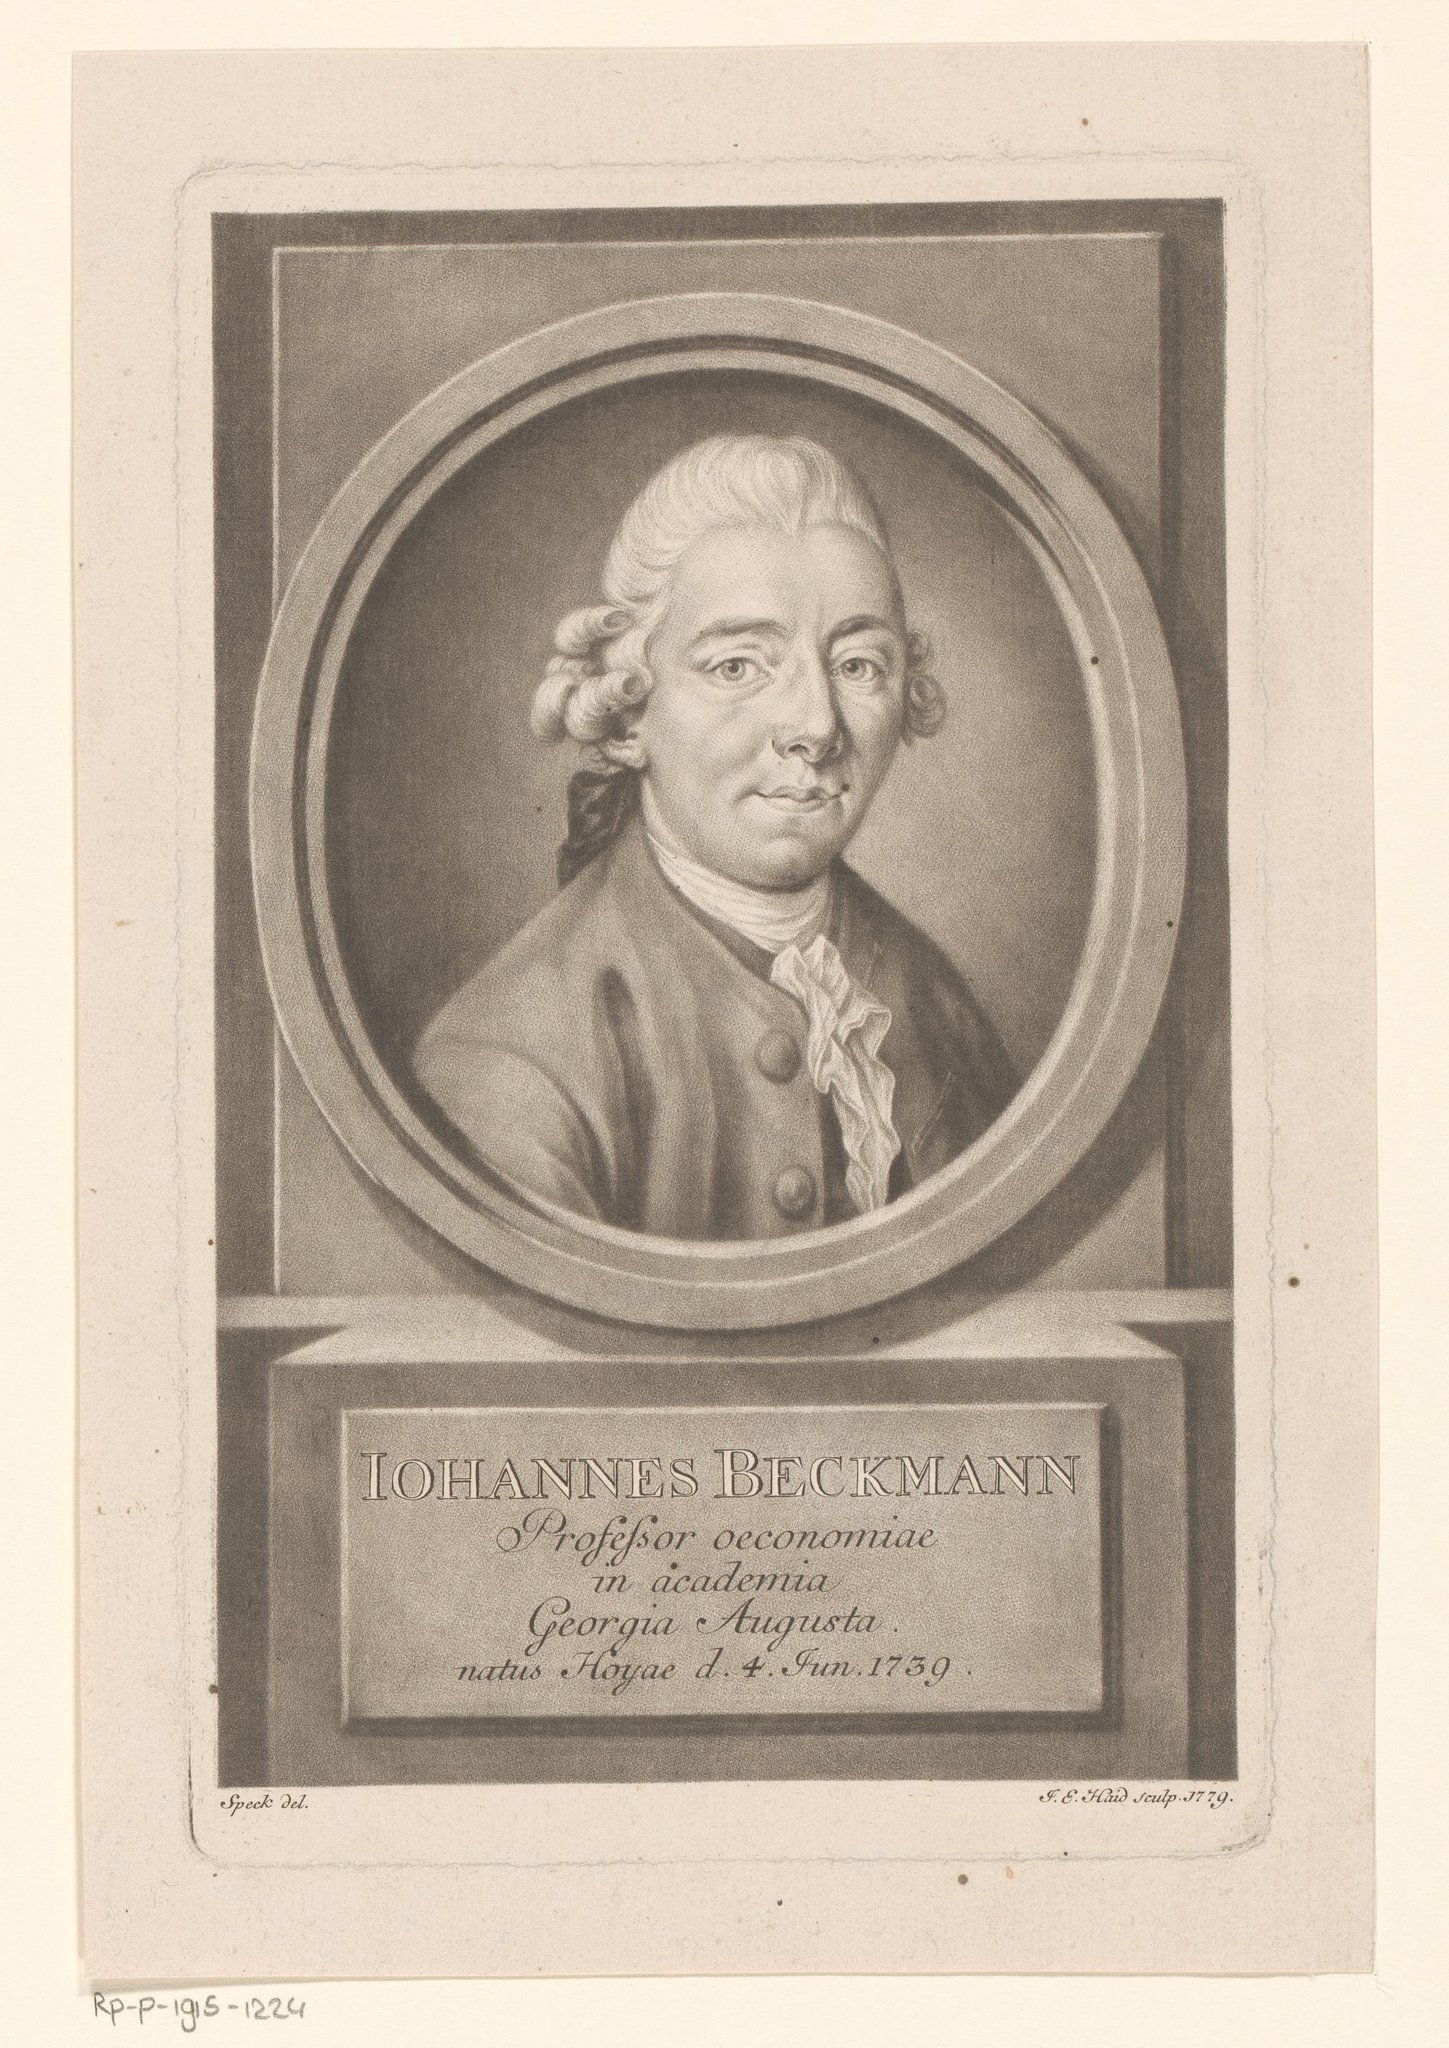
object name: print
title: Portret van Johann Beckmann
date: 1779-1809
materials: paper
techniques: mezzotint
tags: engineering, historical persons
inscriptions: collector's mark: Lugt 2228